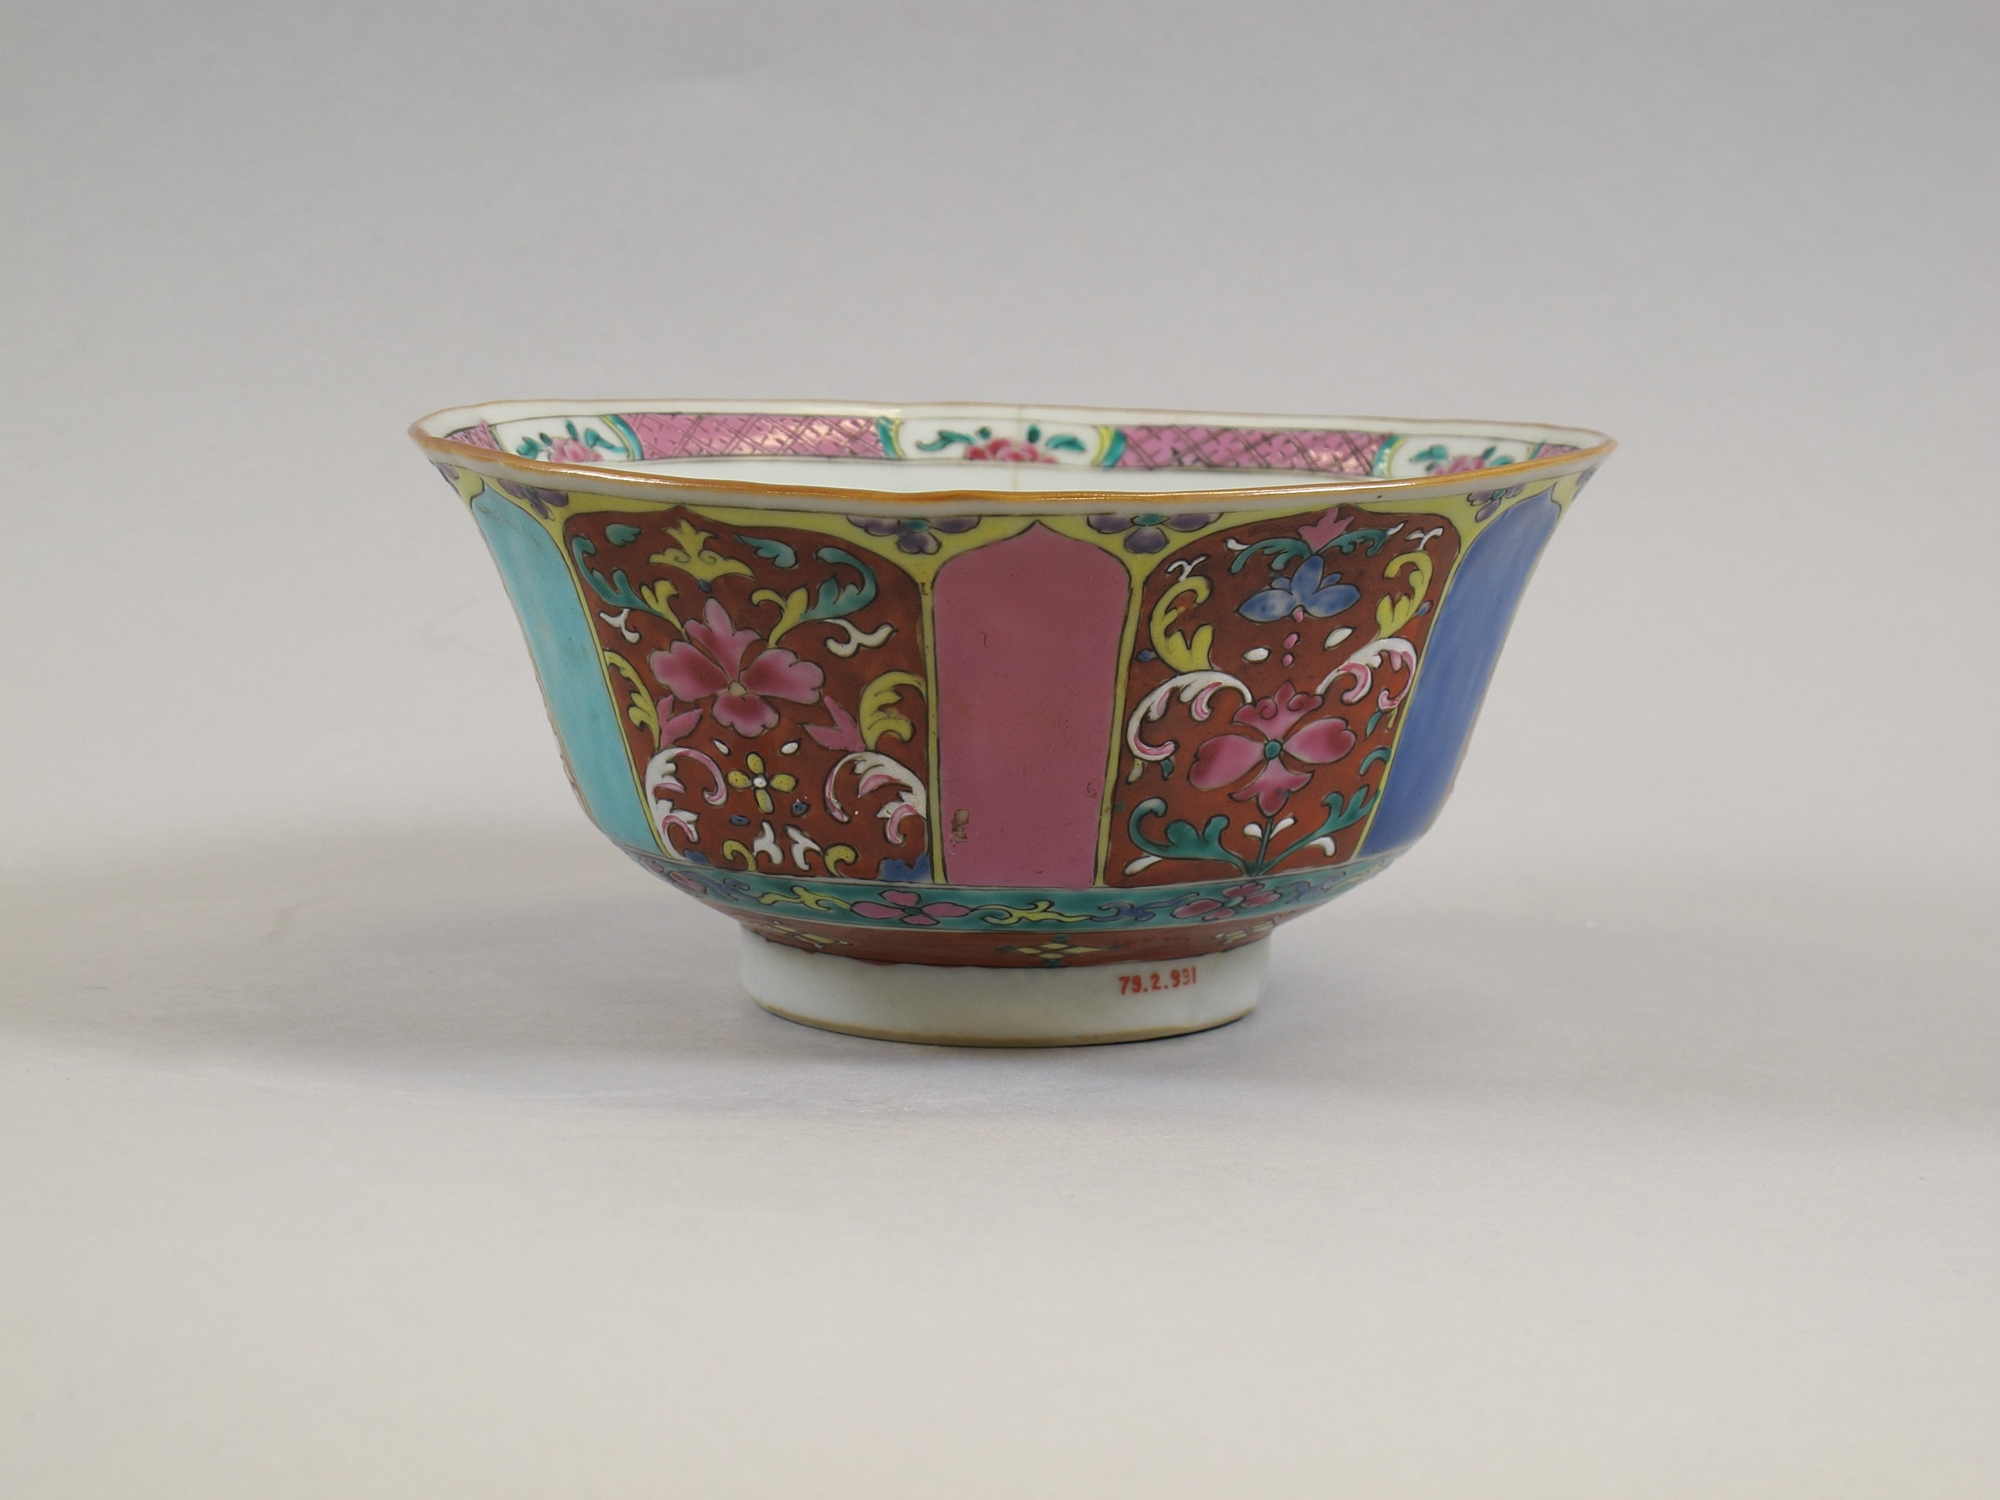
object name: bowl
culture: chinese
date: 1801-1850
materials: enamel, iron, porcelain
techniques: overglaze, painting, polychrome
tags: flowers